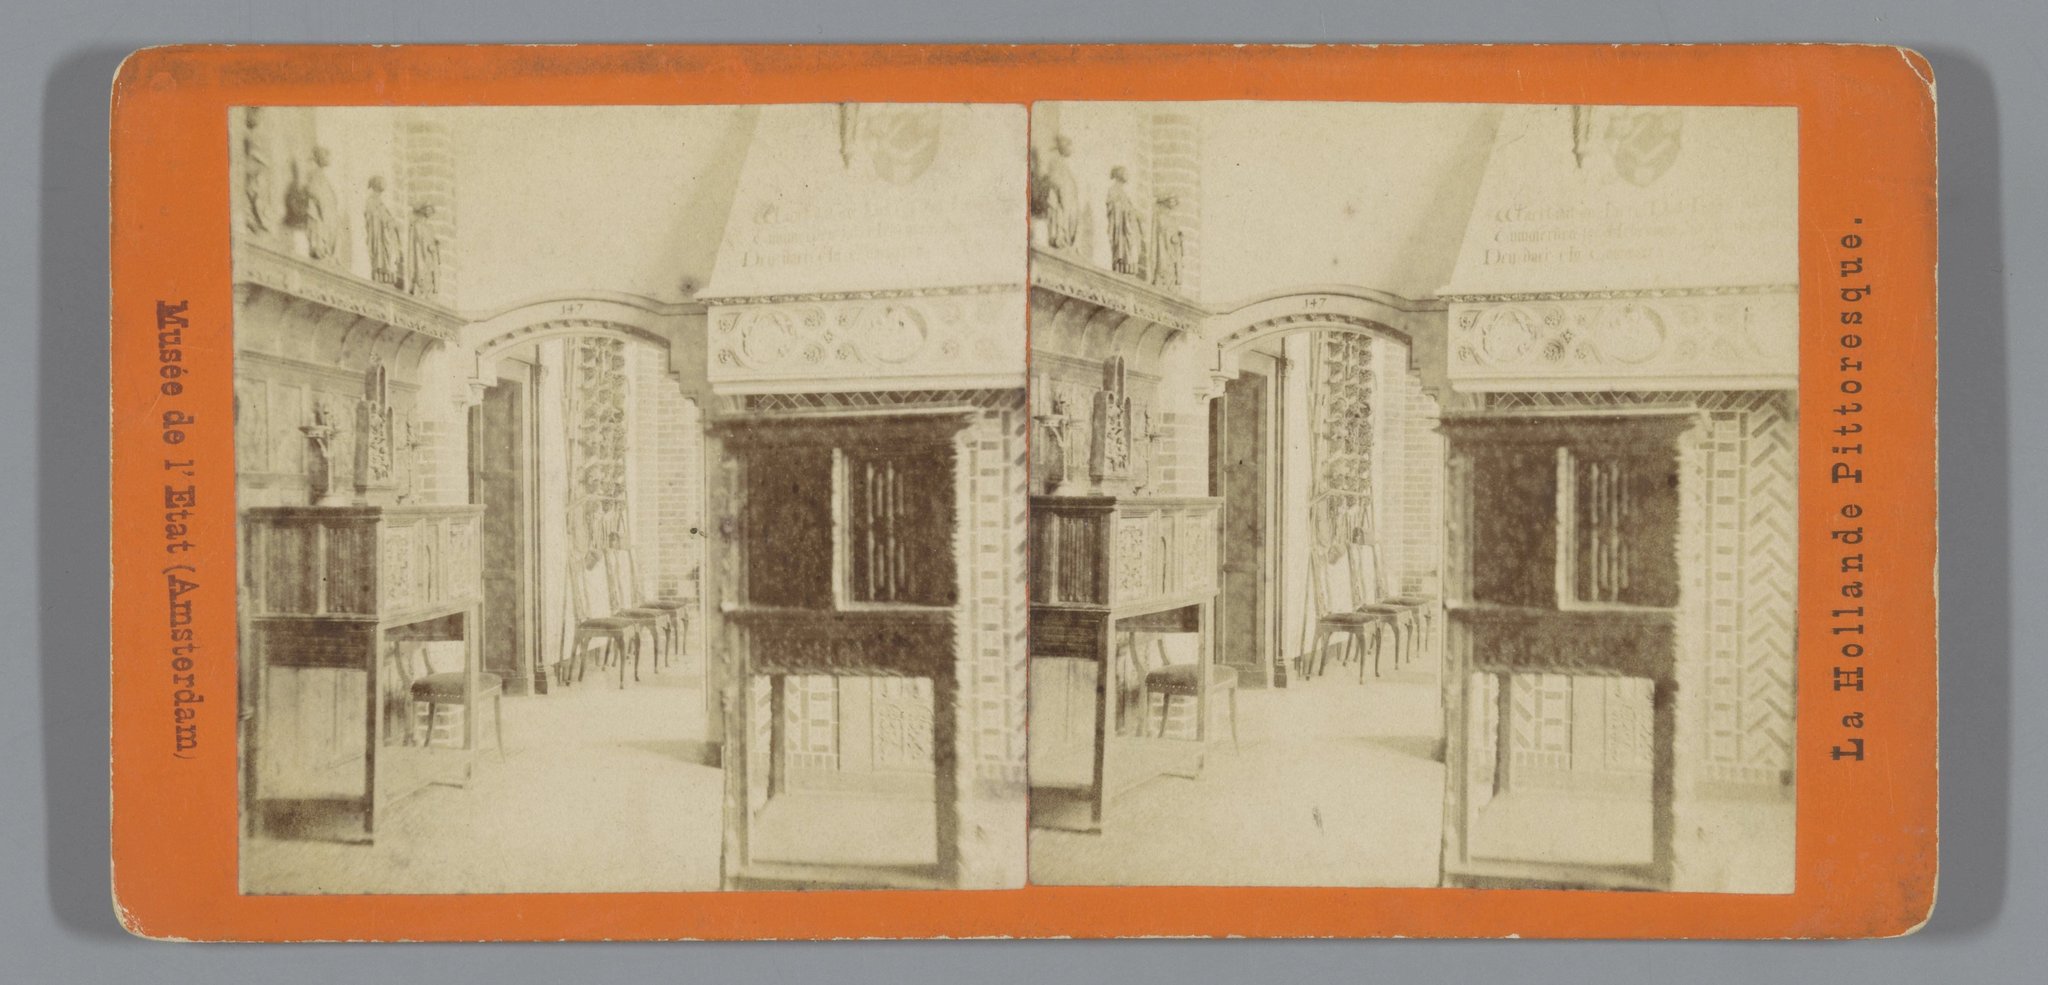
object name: stereograph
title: La Hollandde pittoresque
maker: andreas theodorus rooswinkel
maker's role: fotograaf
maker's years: 1838-1909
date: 1885-1906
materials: cardboard, paper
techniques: albumen print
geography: netherlands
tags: collection, exhibition, show